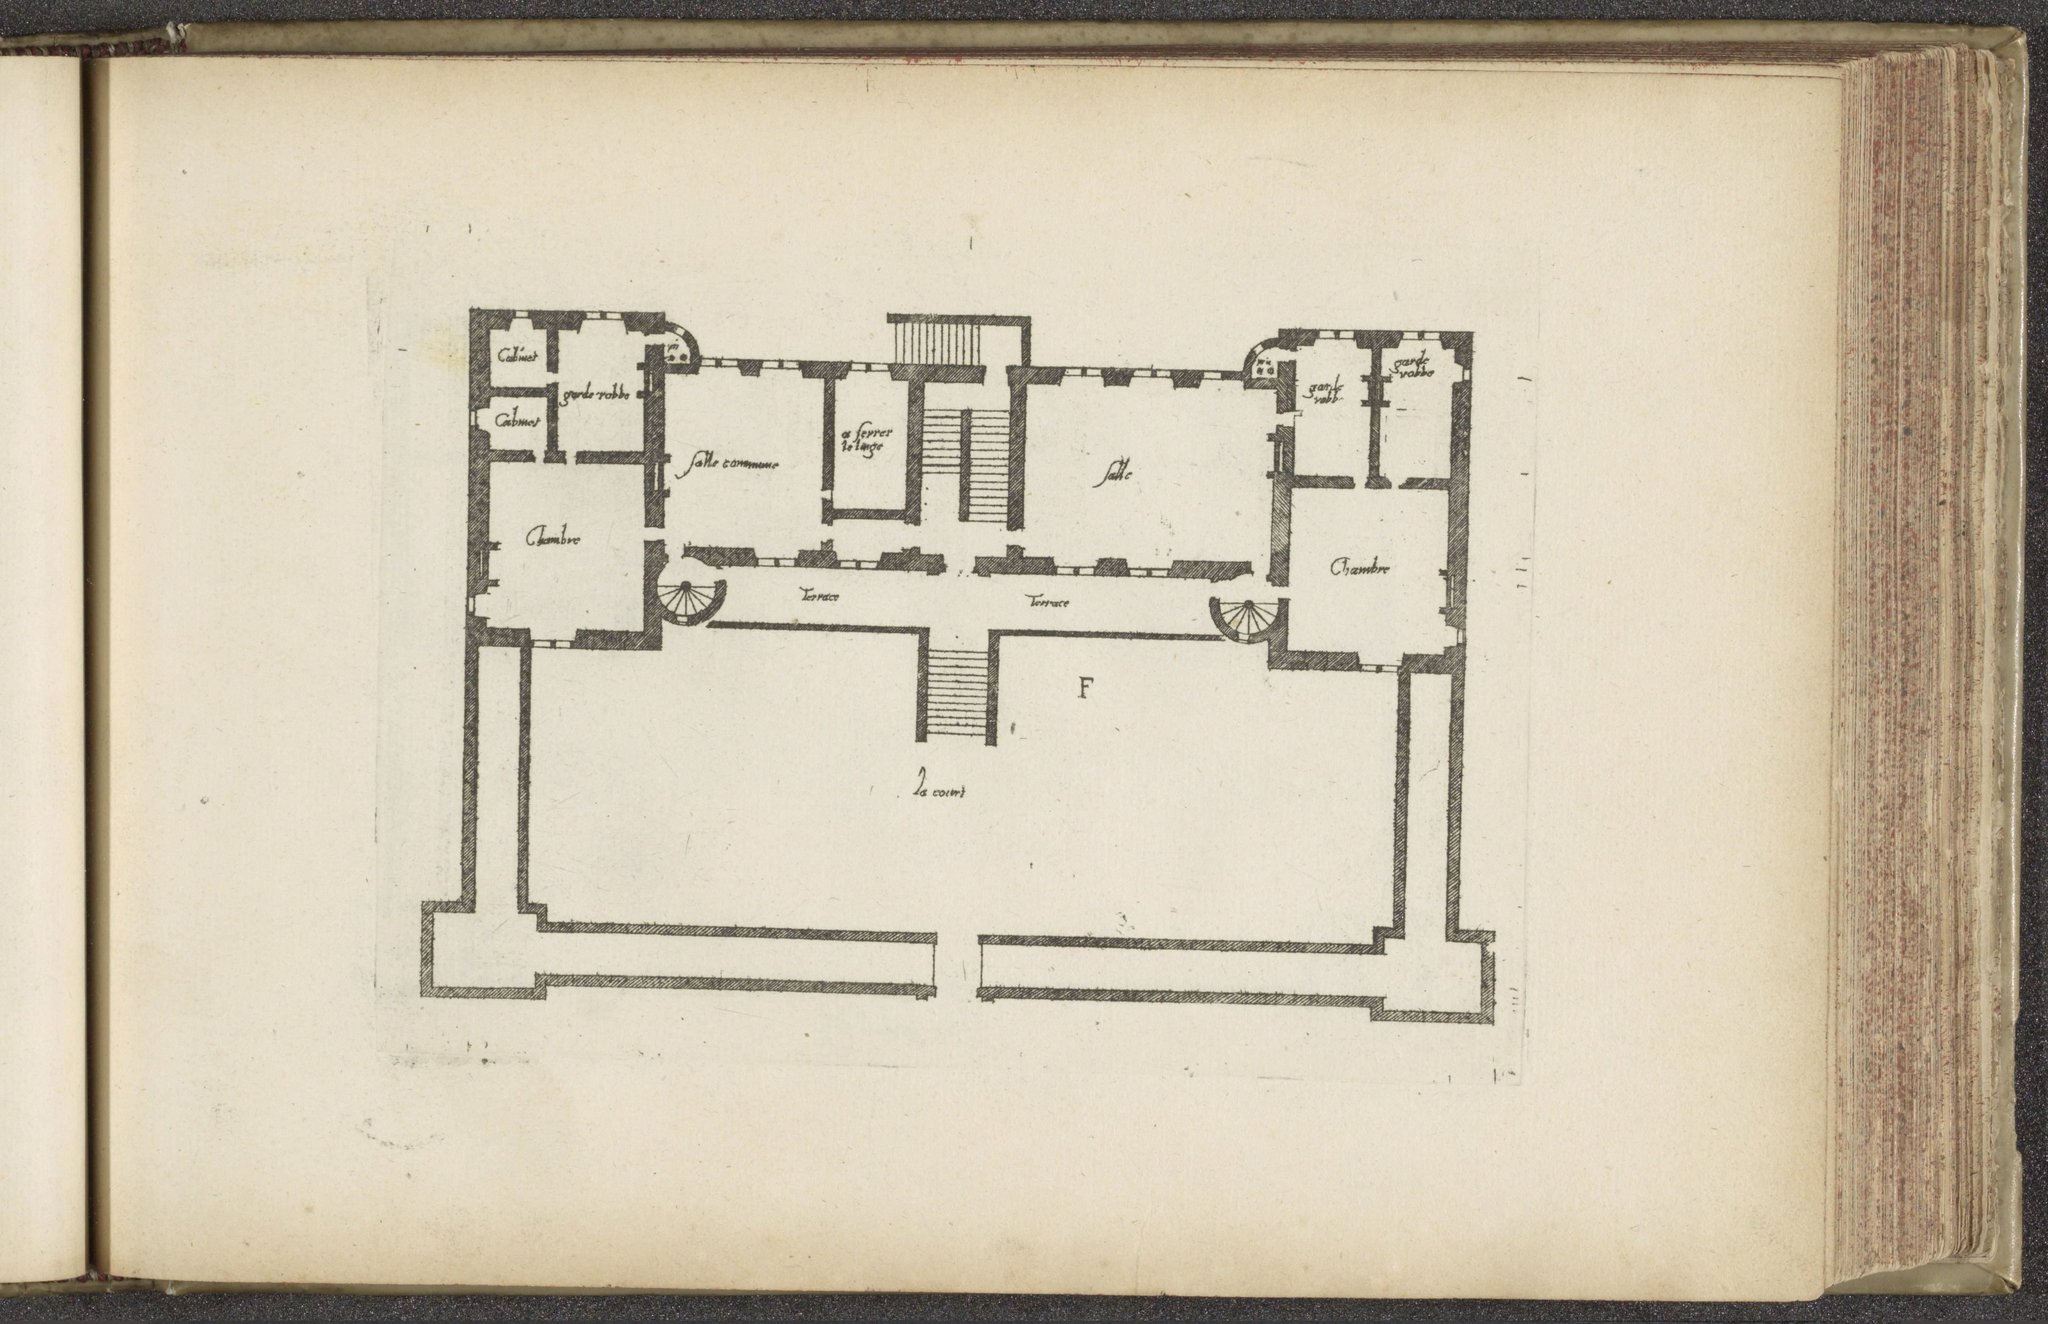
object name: print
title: Plattegronden en modellen van Franse landhuizen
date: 1540-1545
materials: paper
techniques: etching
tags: plan ~ architecture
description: Deze prent maakt deel uit van een album.